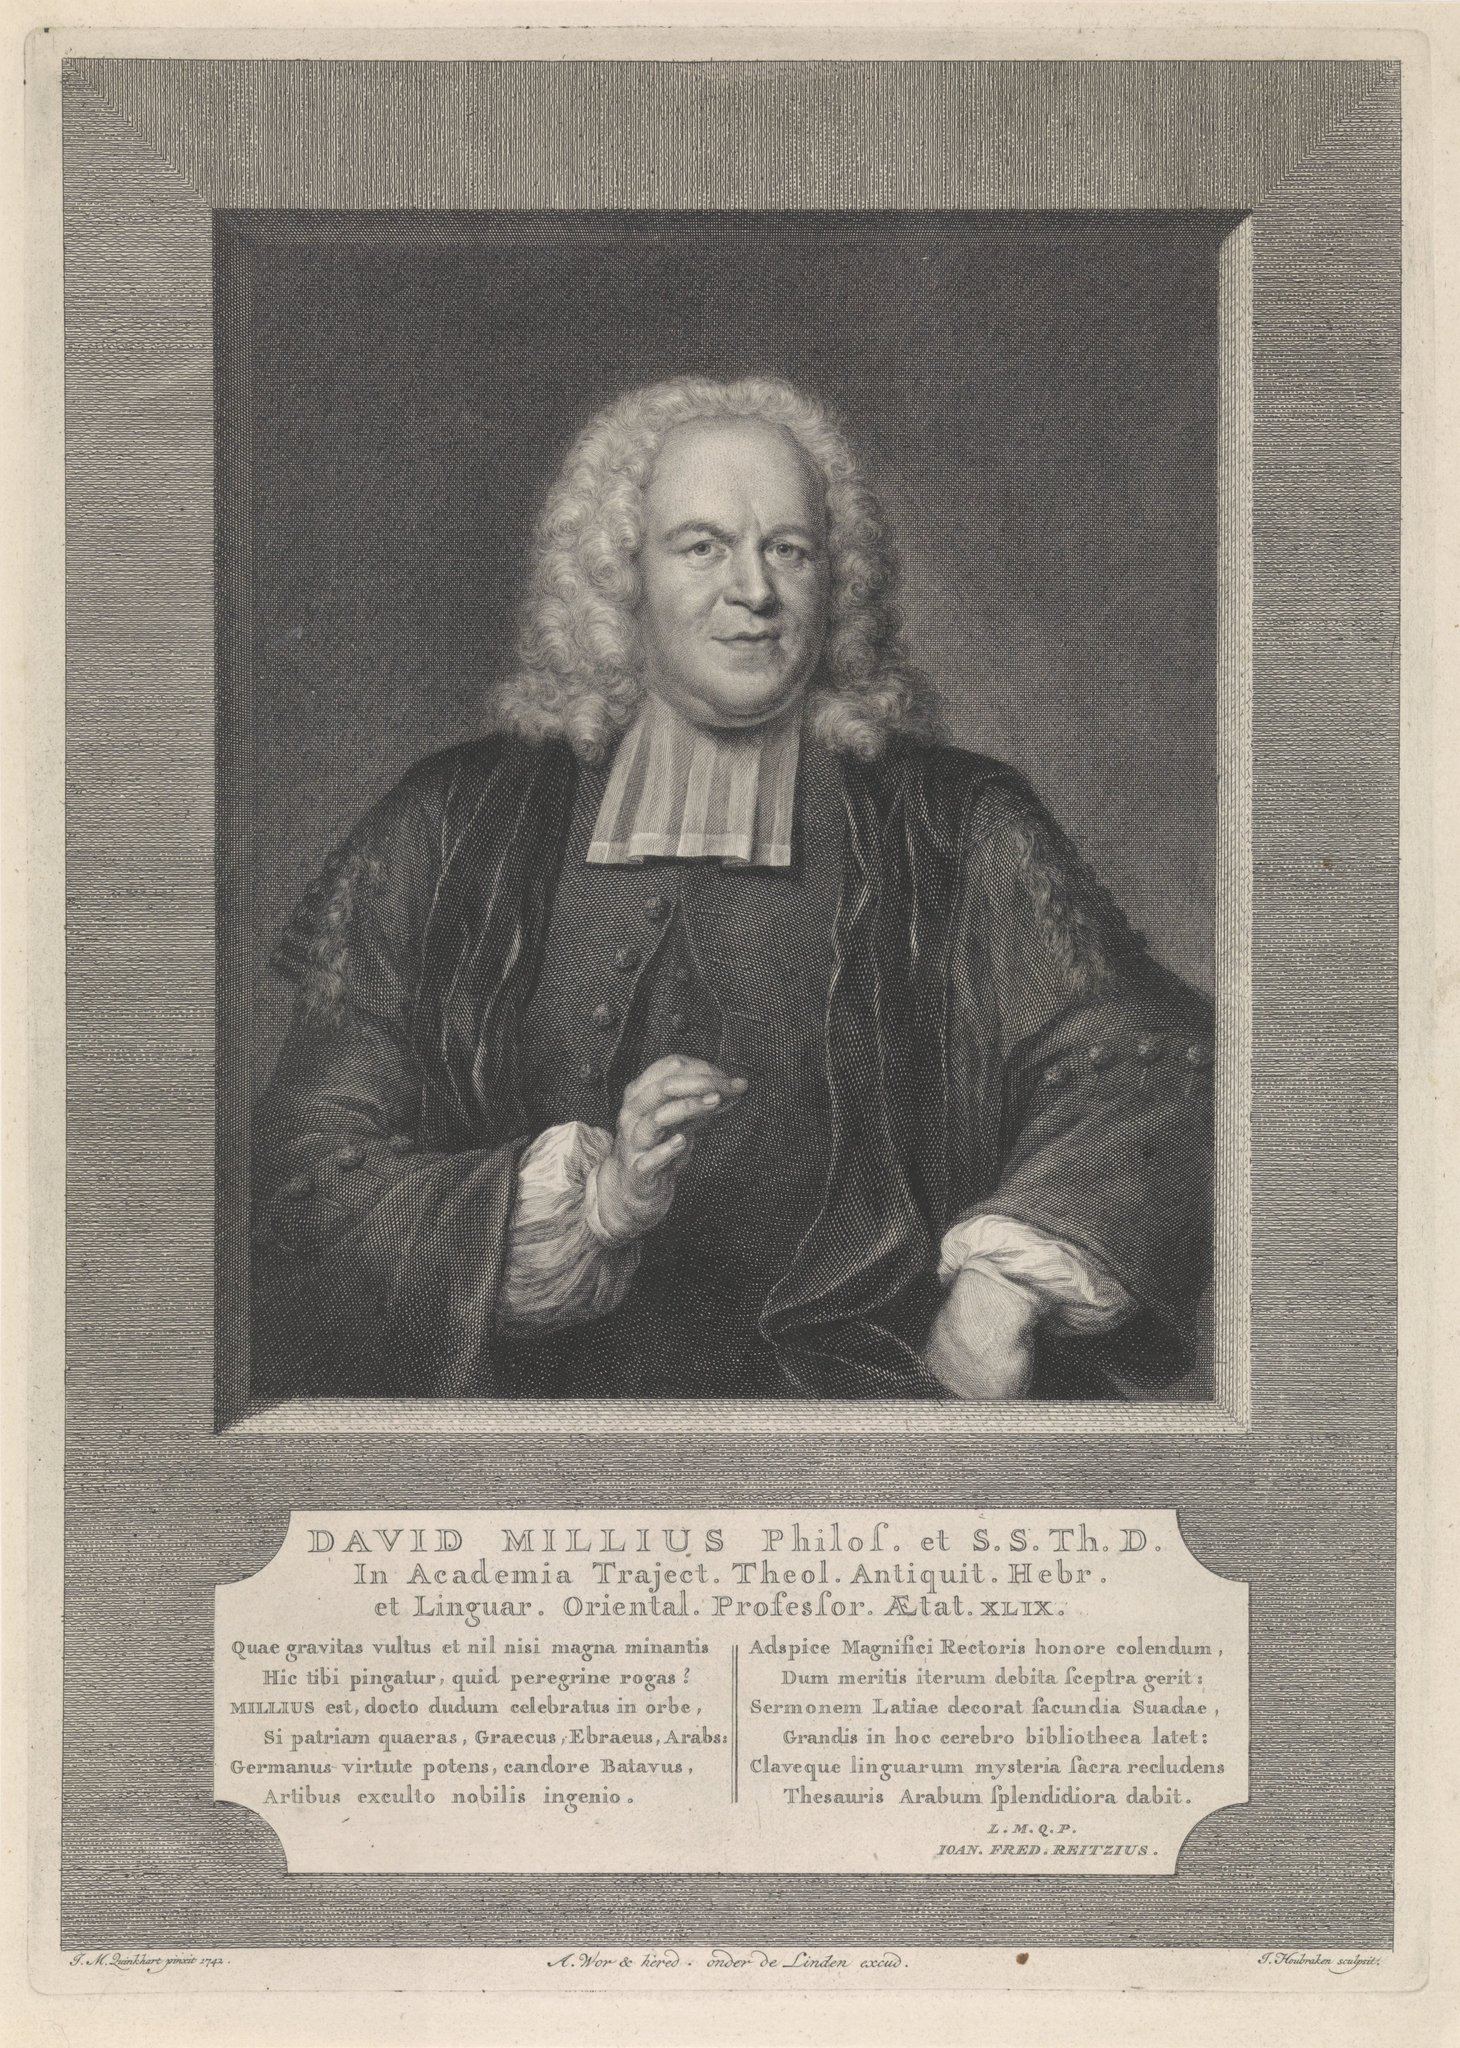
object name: print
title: Portret van David Millius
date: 1742-1750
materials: paper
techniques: engraving, etching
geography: amsterdam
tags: utrecht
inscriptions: collector's mark: Lugt 2228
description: Portret ten halven lijve van David Millius in een rechthoekig venster. Onder het portret zijn naam en gegevens in drie regels in het Latijn een daaronder twee kolommen met elk zes regels in het Latijn.